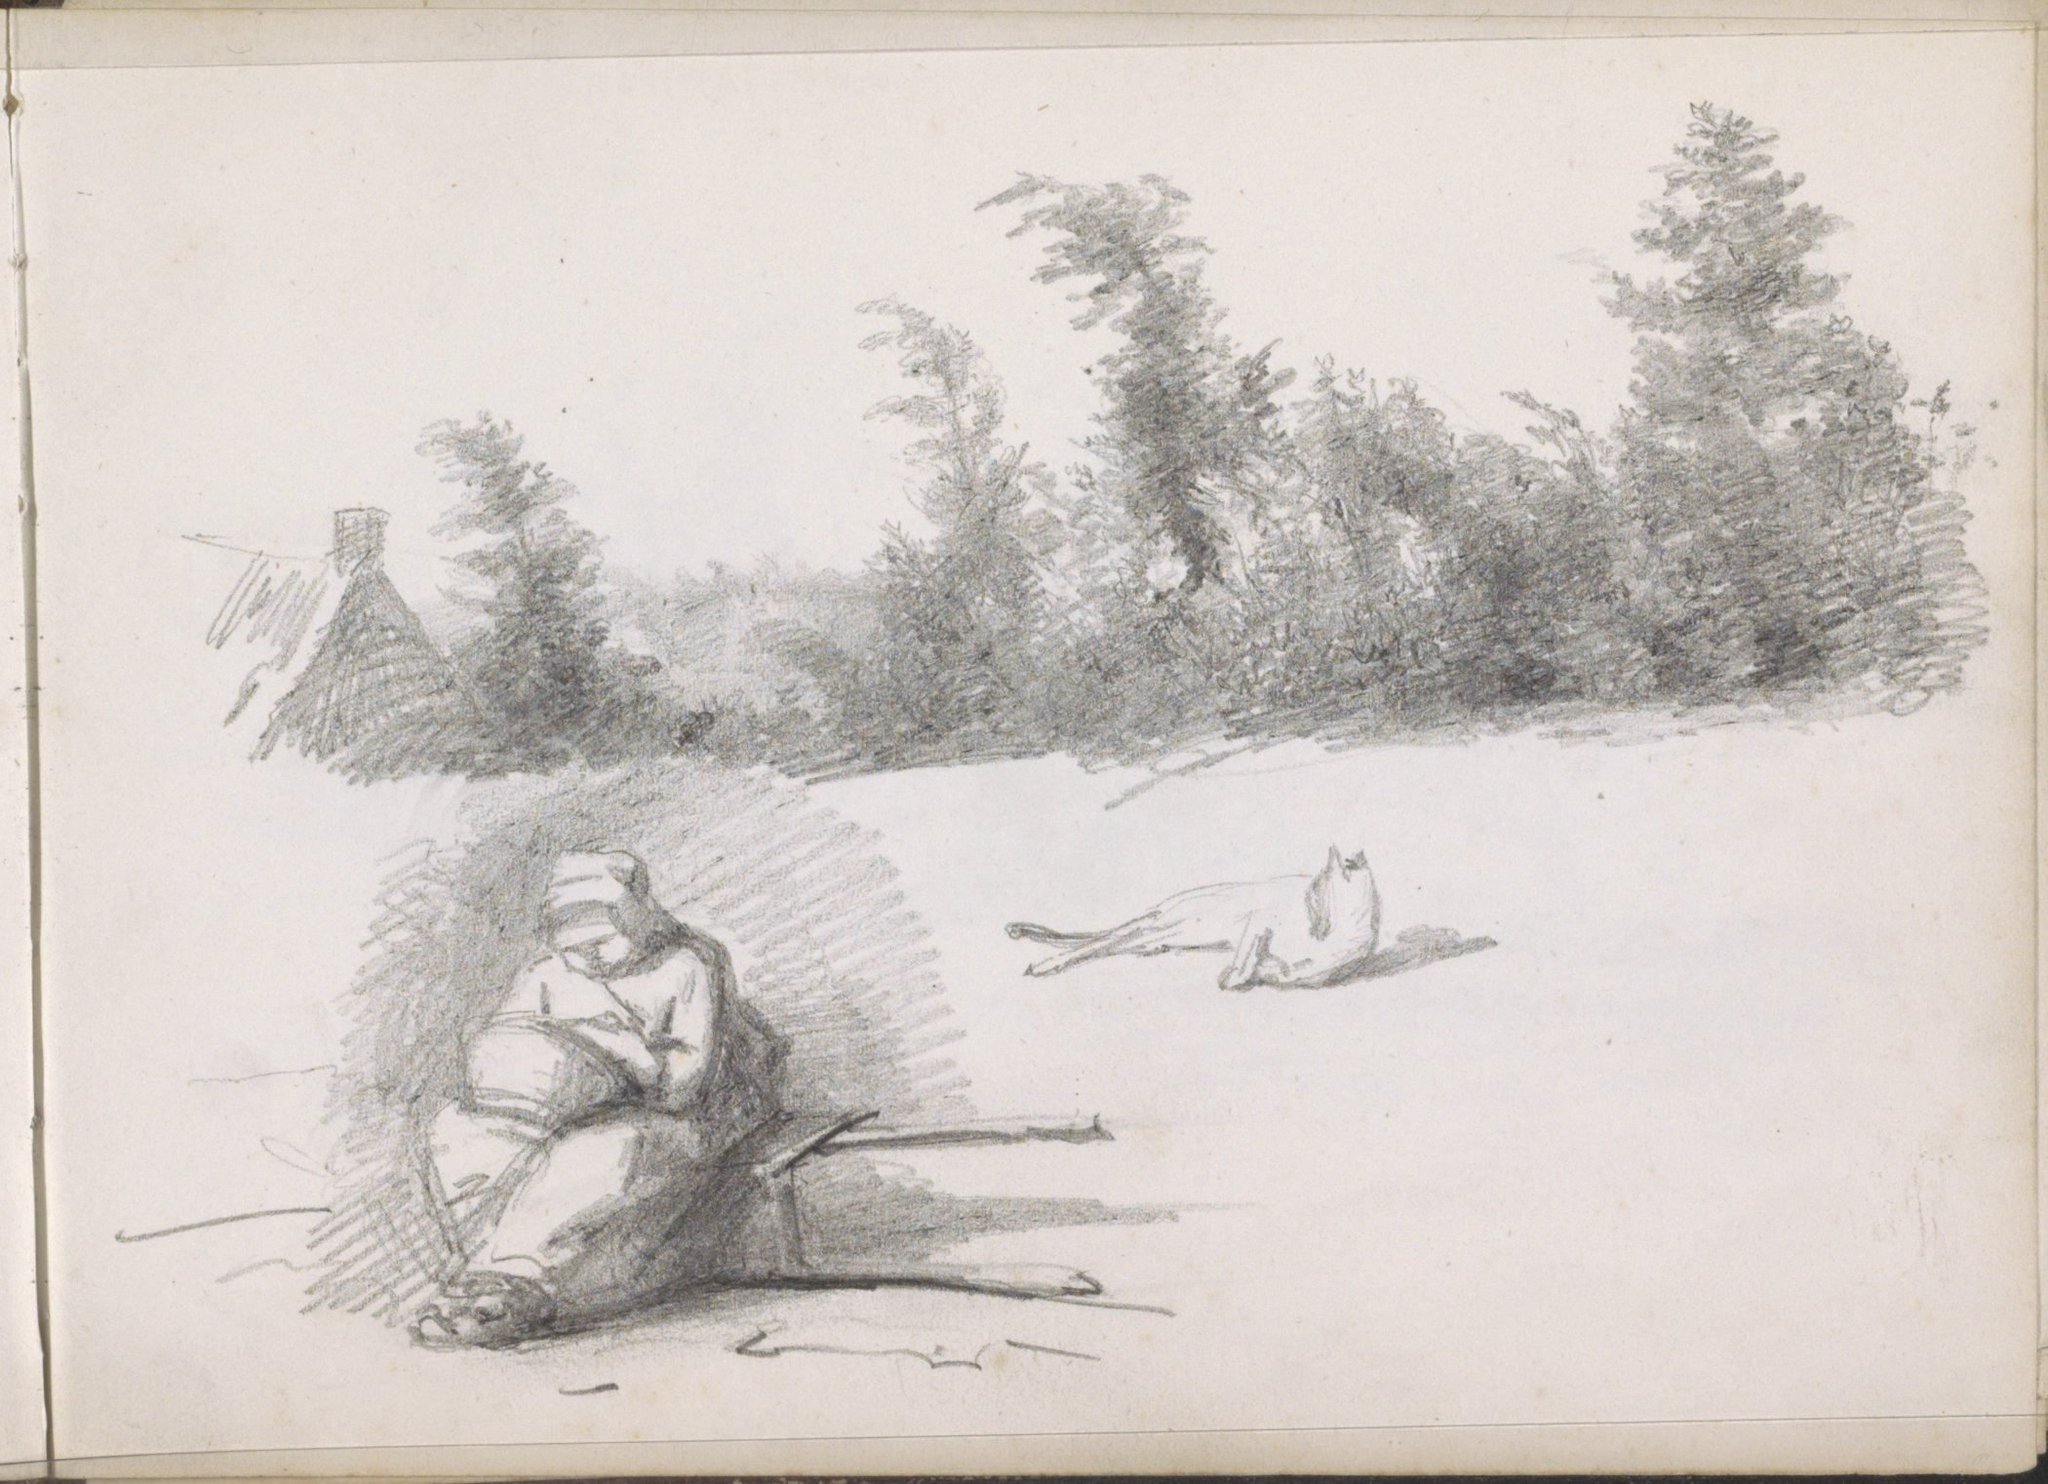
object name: sketchbook leaf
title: Studieblad, onder andere met boomtoppen naast het puntdak van een huis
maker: maria vos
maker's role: draughtsman, painter, print maker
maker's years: 1824-1906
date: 1834-1906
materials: paper, pencil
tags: trees, sitting figure, cat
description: Tevens studies van een liggende kat en een meisje met een mand op schoot. Blad 25 recto uit een schetsboek met 30 bladen.